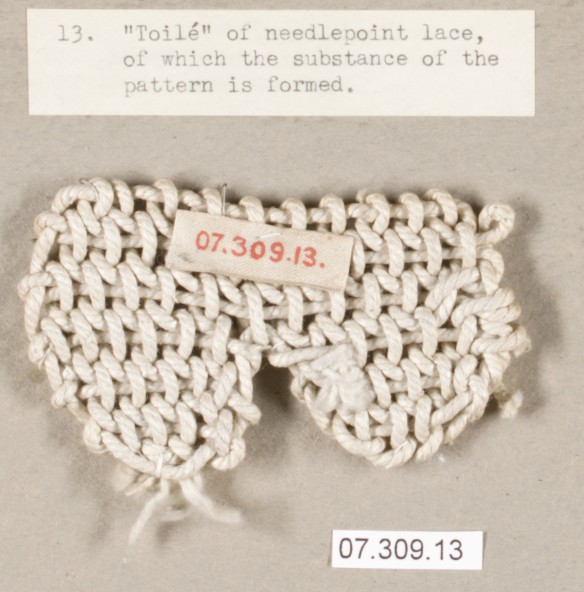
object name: stitch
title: Example of lace stitch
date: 1801-2000